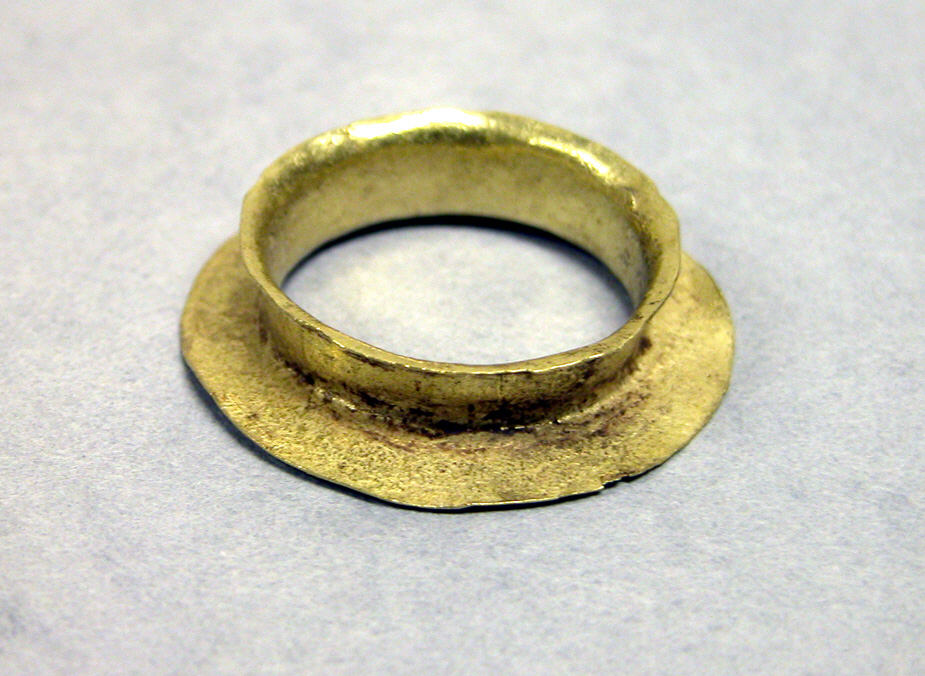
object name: pair of earring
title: Pair of Earrings, Hammered Sheet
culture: indonesian, central java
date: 701-1200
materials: gold